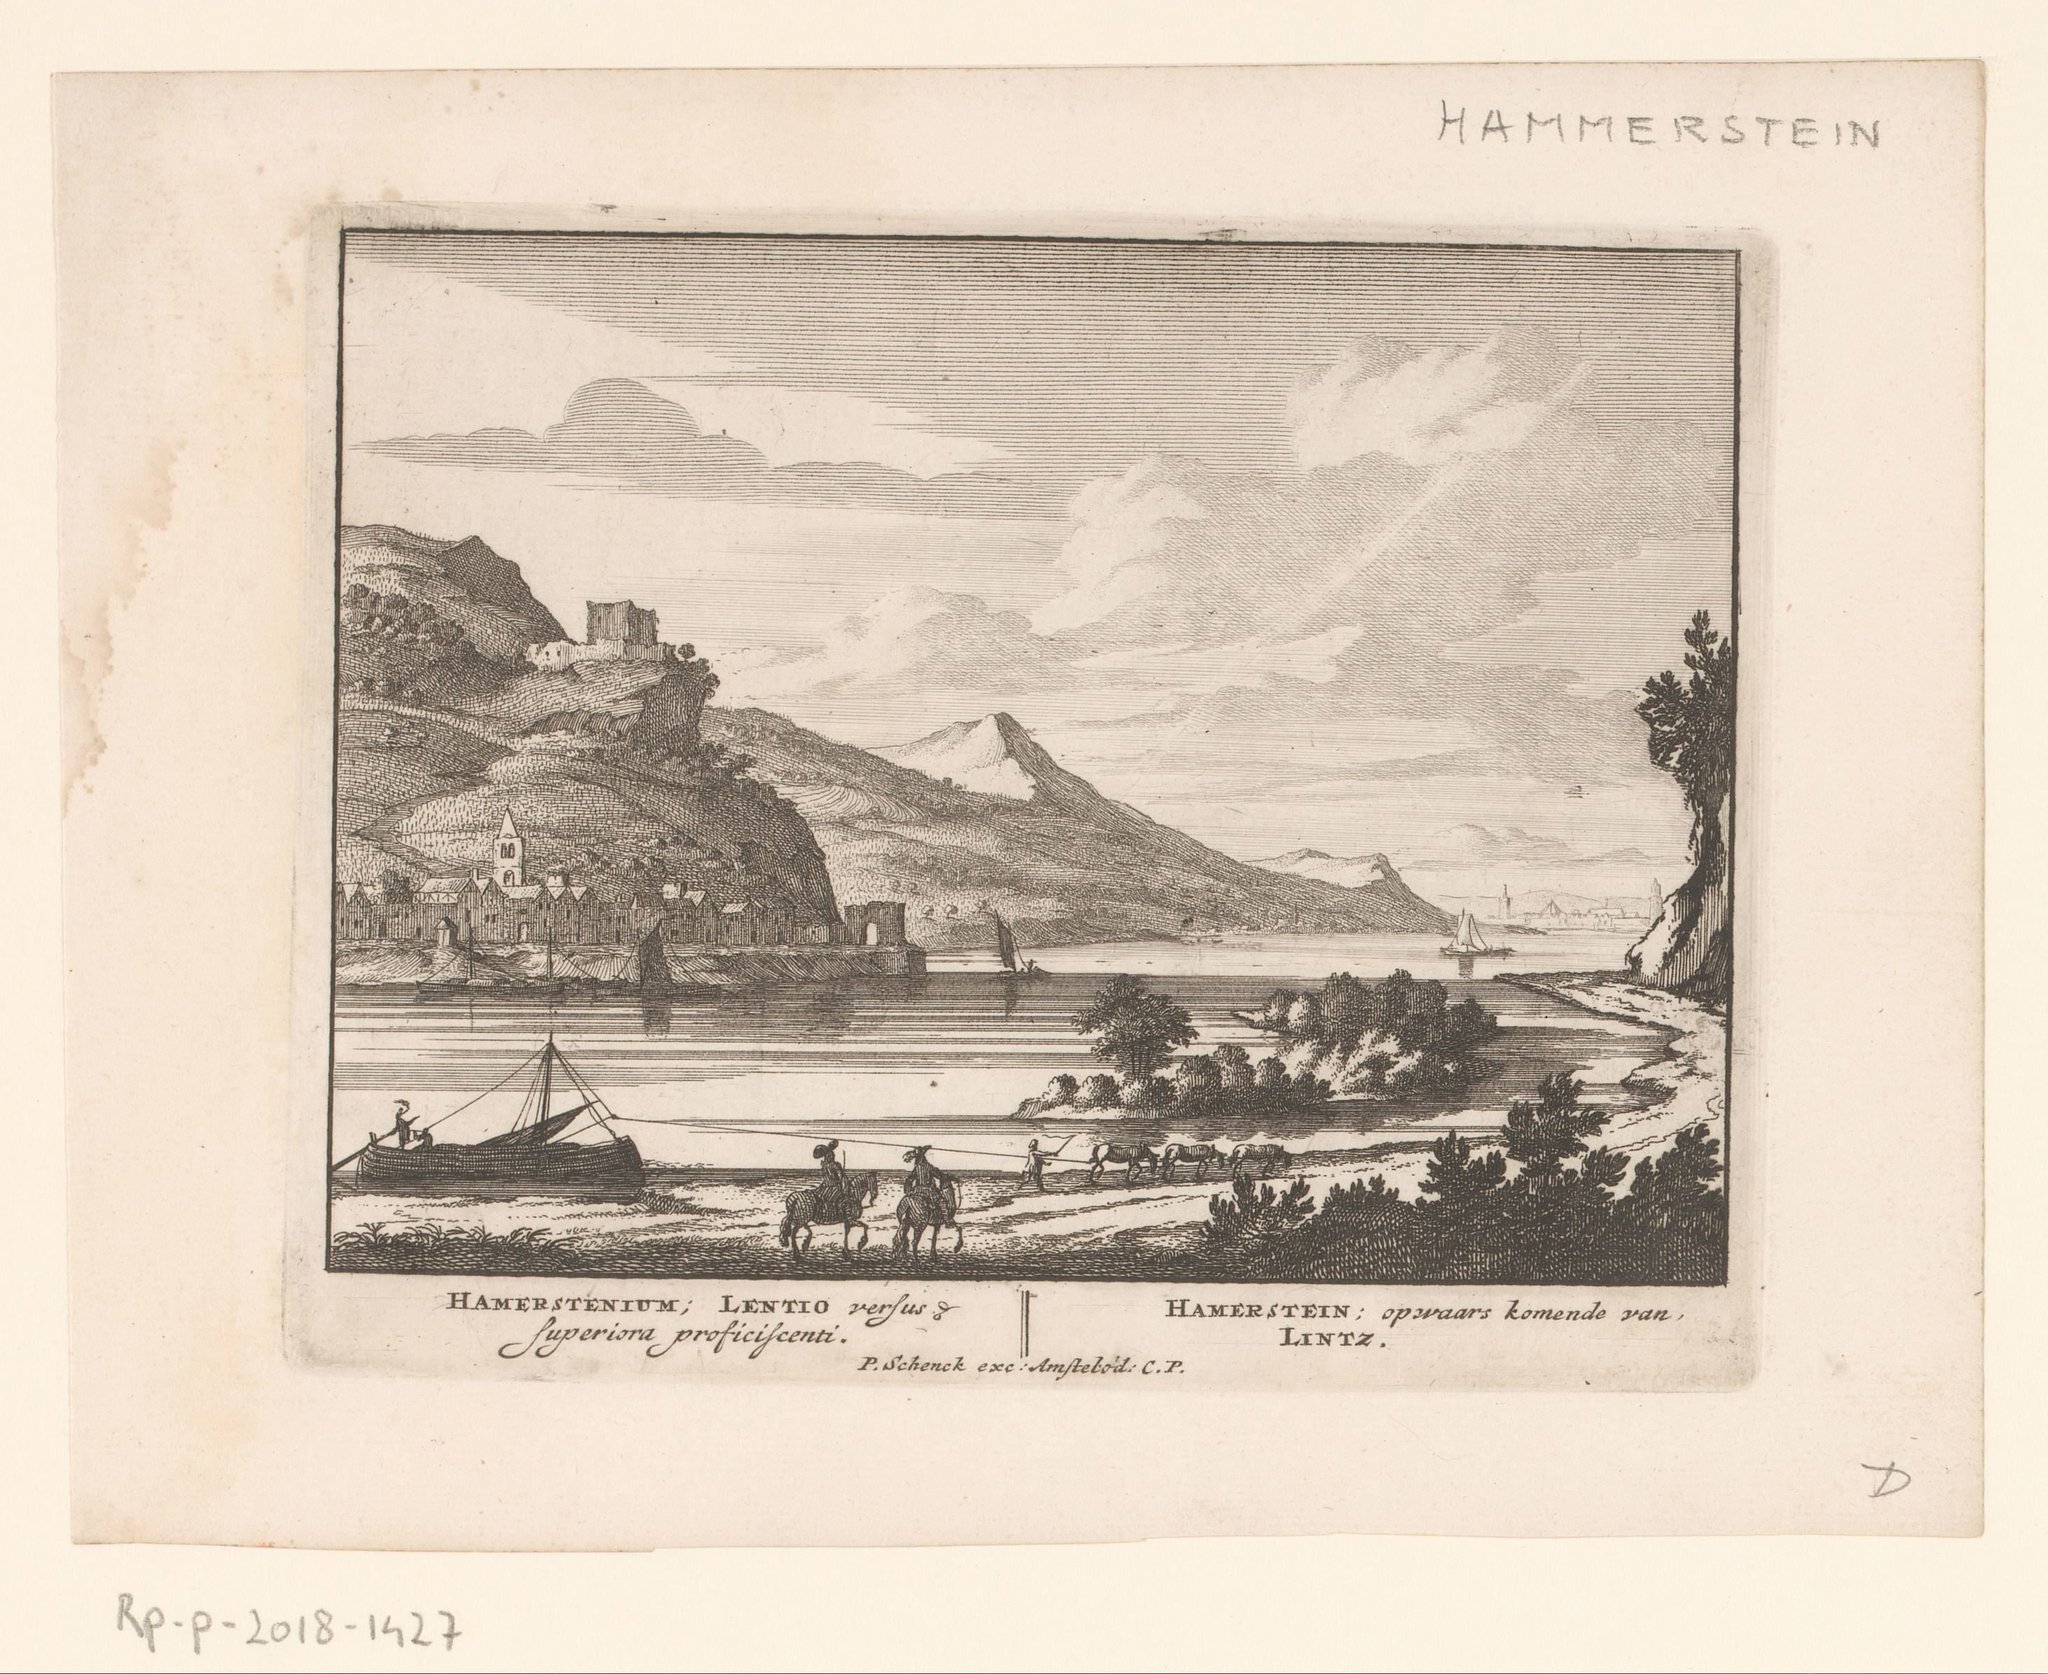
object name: print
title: Hamerstein; opwars komende van Lintz / Hamerstenium; Lentio versus superiora proficiscenti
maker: pieter schenk (i)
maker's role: print maker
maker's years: 1660-1711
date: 1694-1697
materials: paper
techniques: engraving, etching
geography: amsterdam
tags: prospect of village, silhouette of village, river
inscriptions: collector's mark: Lugt 2228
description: Prent ook gebruikt in: Admirandorum quadruplex spectaculum / delectum, pictum, et aeri in cisum, per Johannem van Call. Amsterdam: Pieter Schenk (I), ca. 1694-1697.